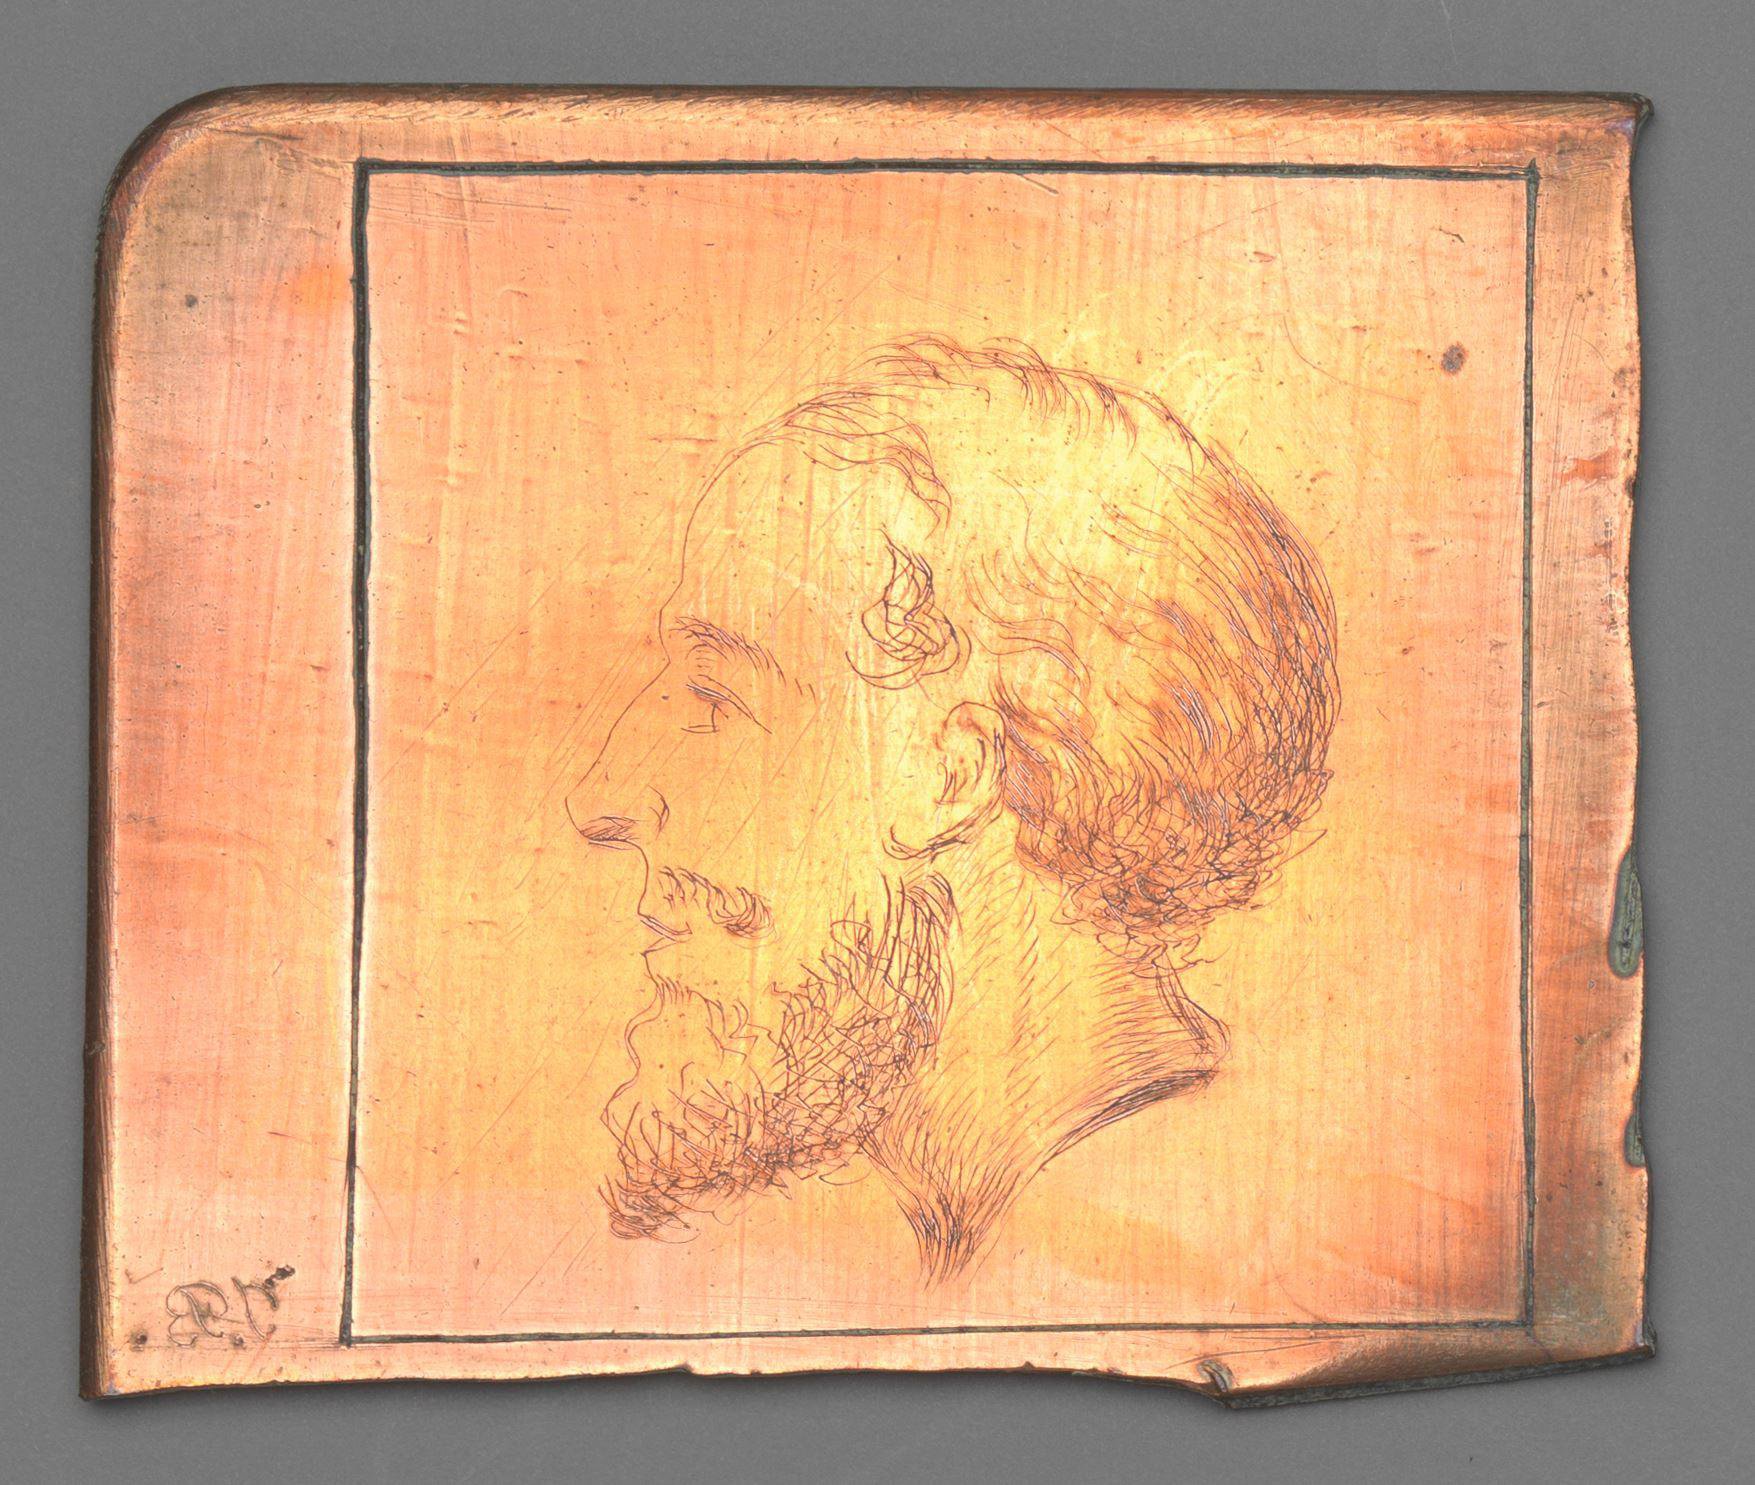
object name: copper plate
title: Kop van een man met baard in profiel naar links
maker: jean bernard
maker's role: draughtsman, print maker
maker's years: 1765-1833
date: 1775-1833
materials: copper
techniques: etching